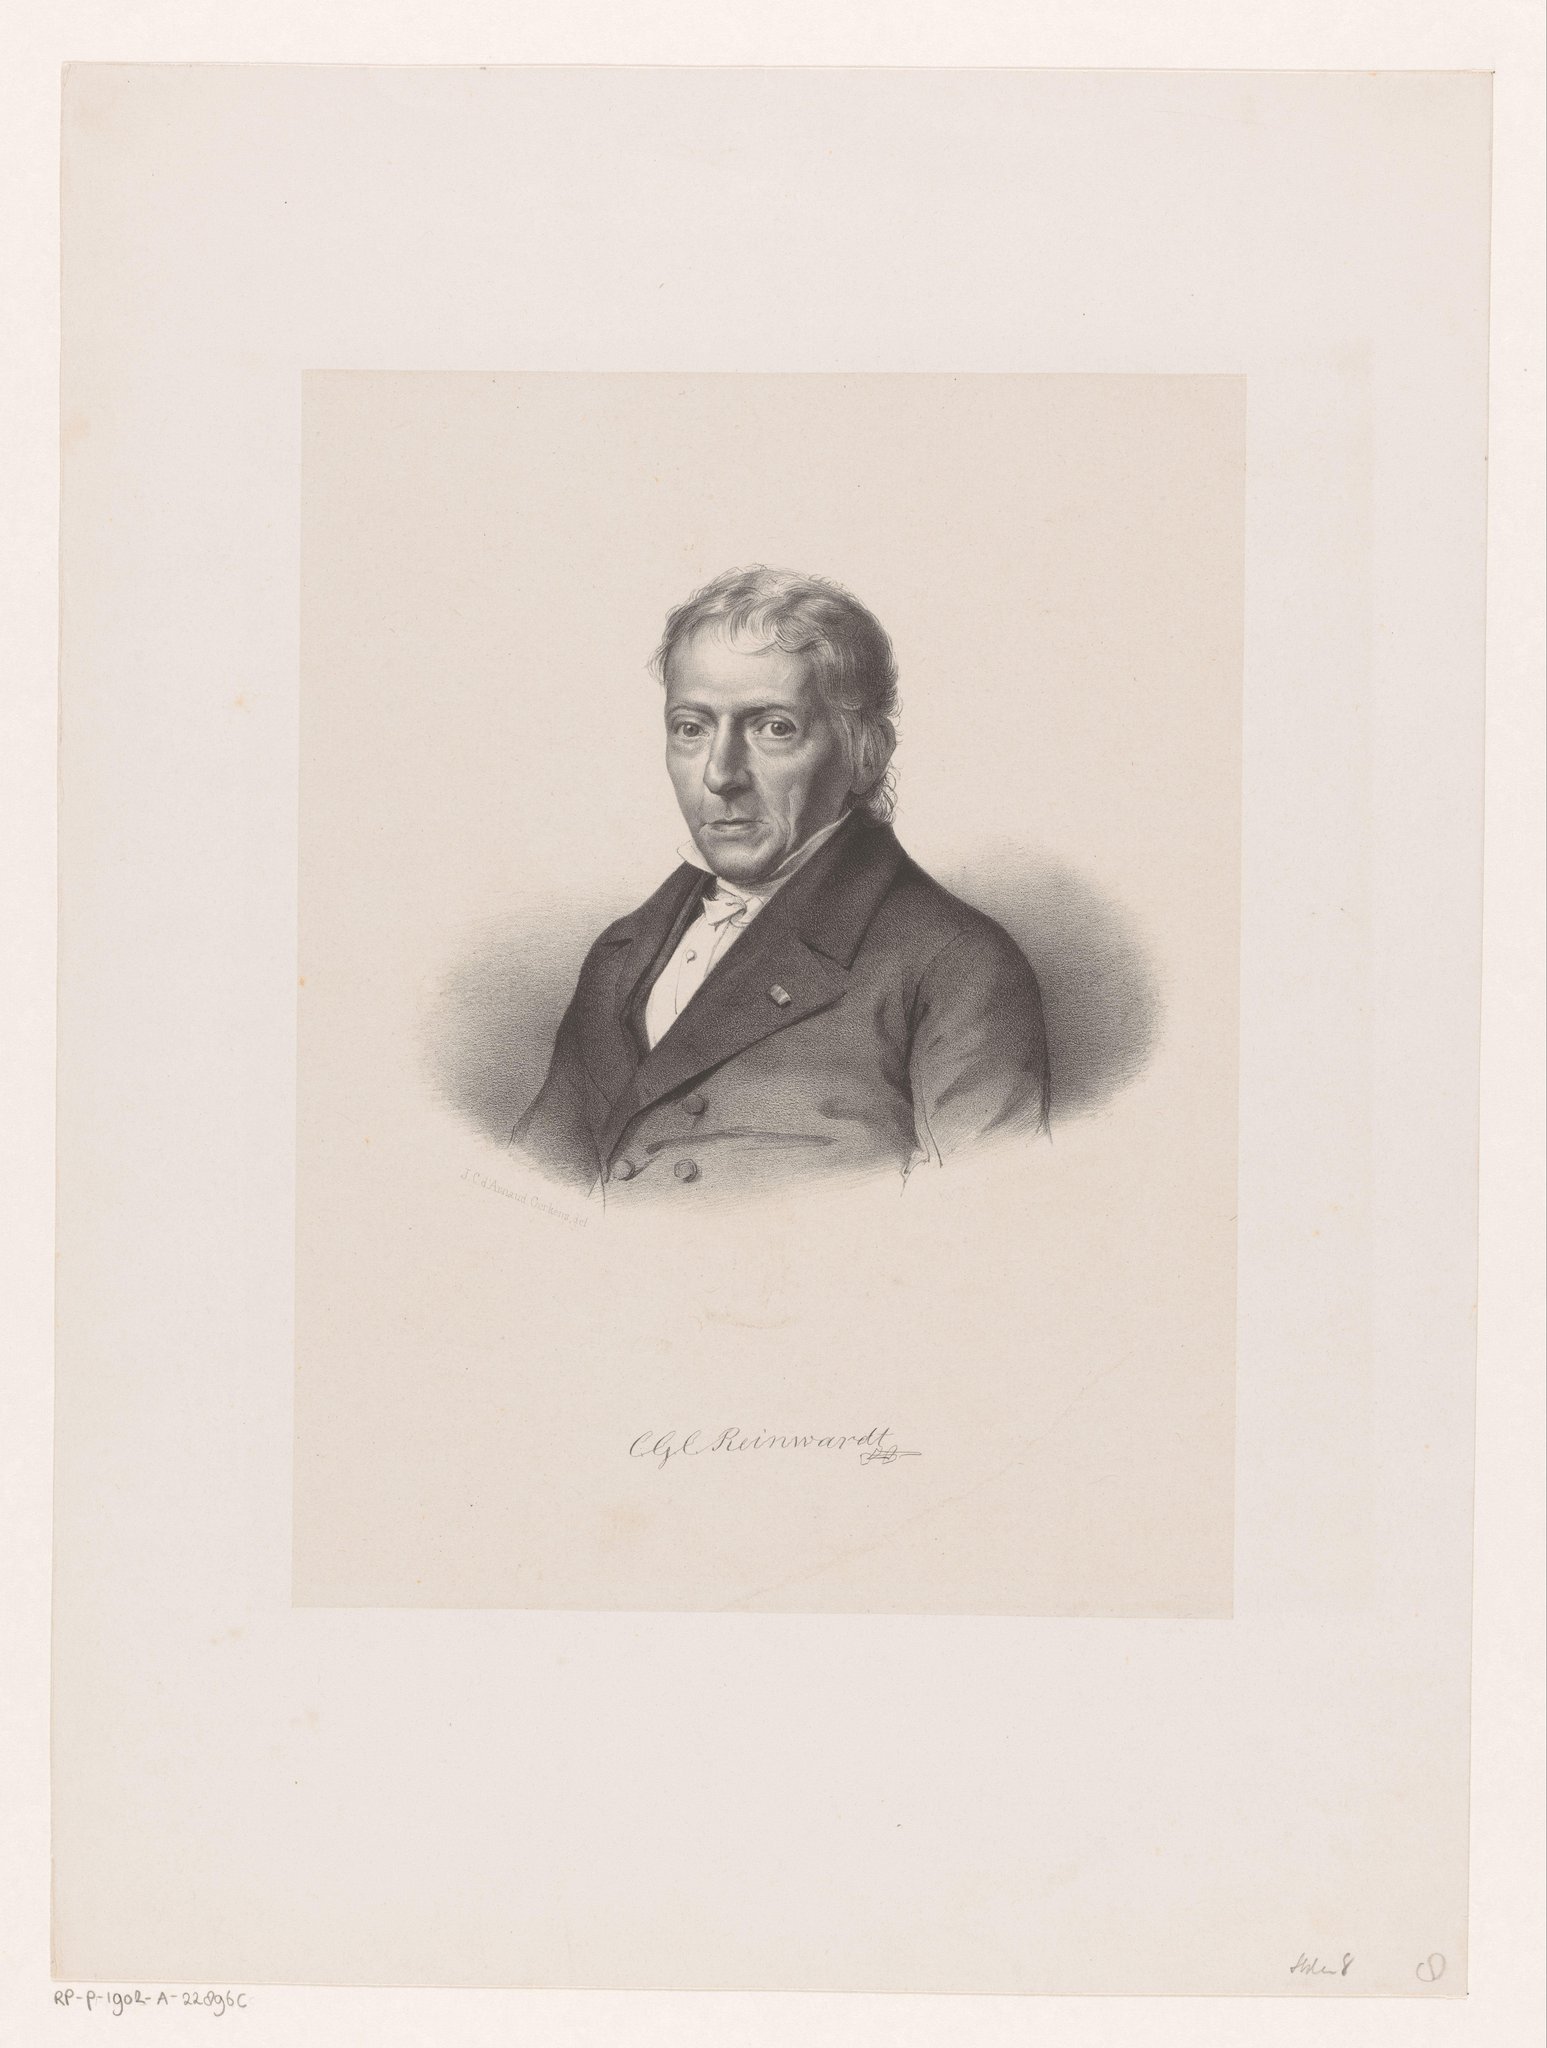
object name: print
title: Portret van Caspar Georg Carl Reinwardt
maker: johannes christiaan d arnaud gerkens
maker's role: draughtsman, print maker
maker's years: 1823-1892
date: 1833-1854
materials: paper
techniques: lithograph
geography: netherlands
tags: caspar georg carl reinwardt, knighthood order, historical persons (+ (full) bust portrait)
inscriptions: collector's mark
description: De geportretteerde draagt een ridderorde in zijn knoopsgat. Onder het portret zijn signatuur.